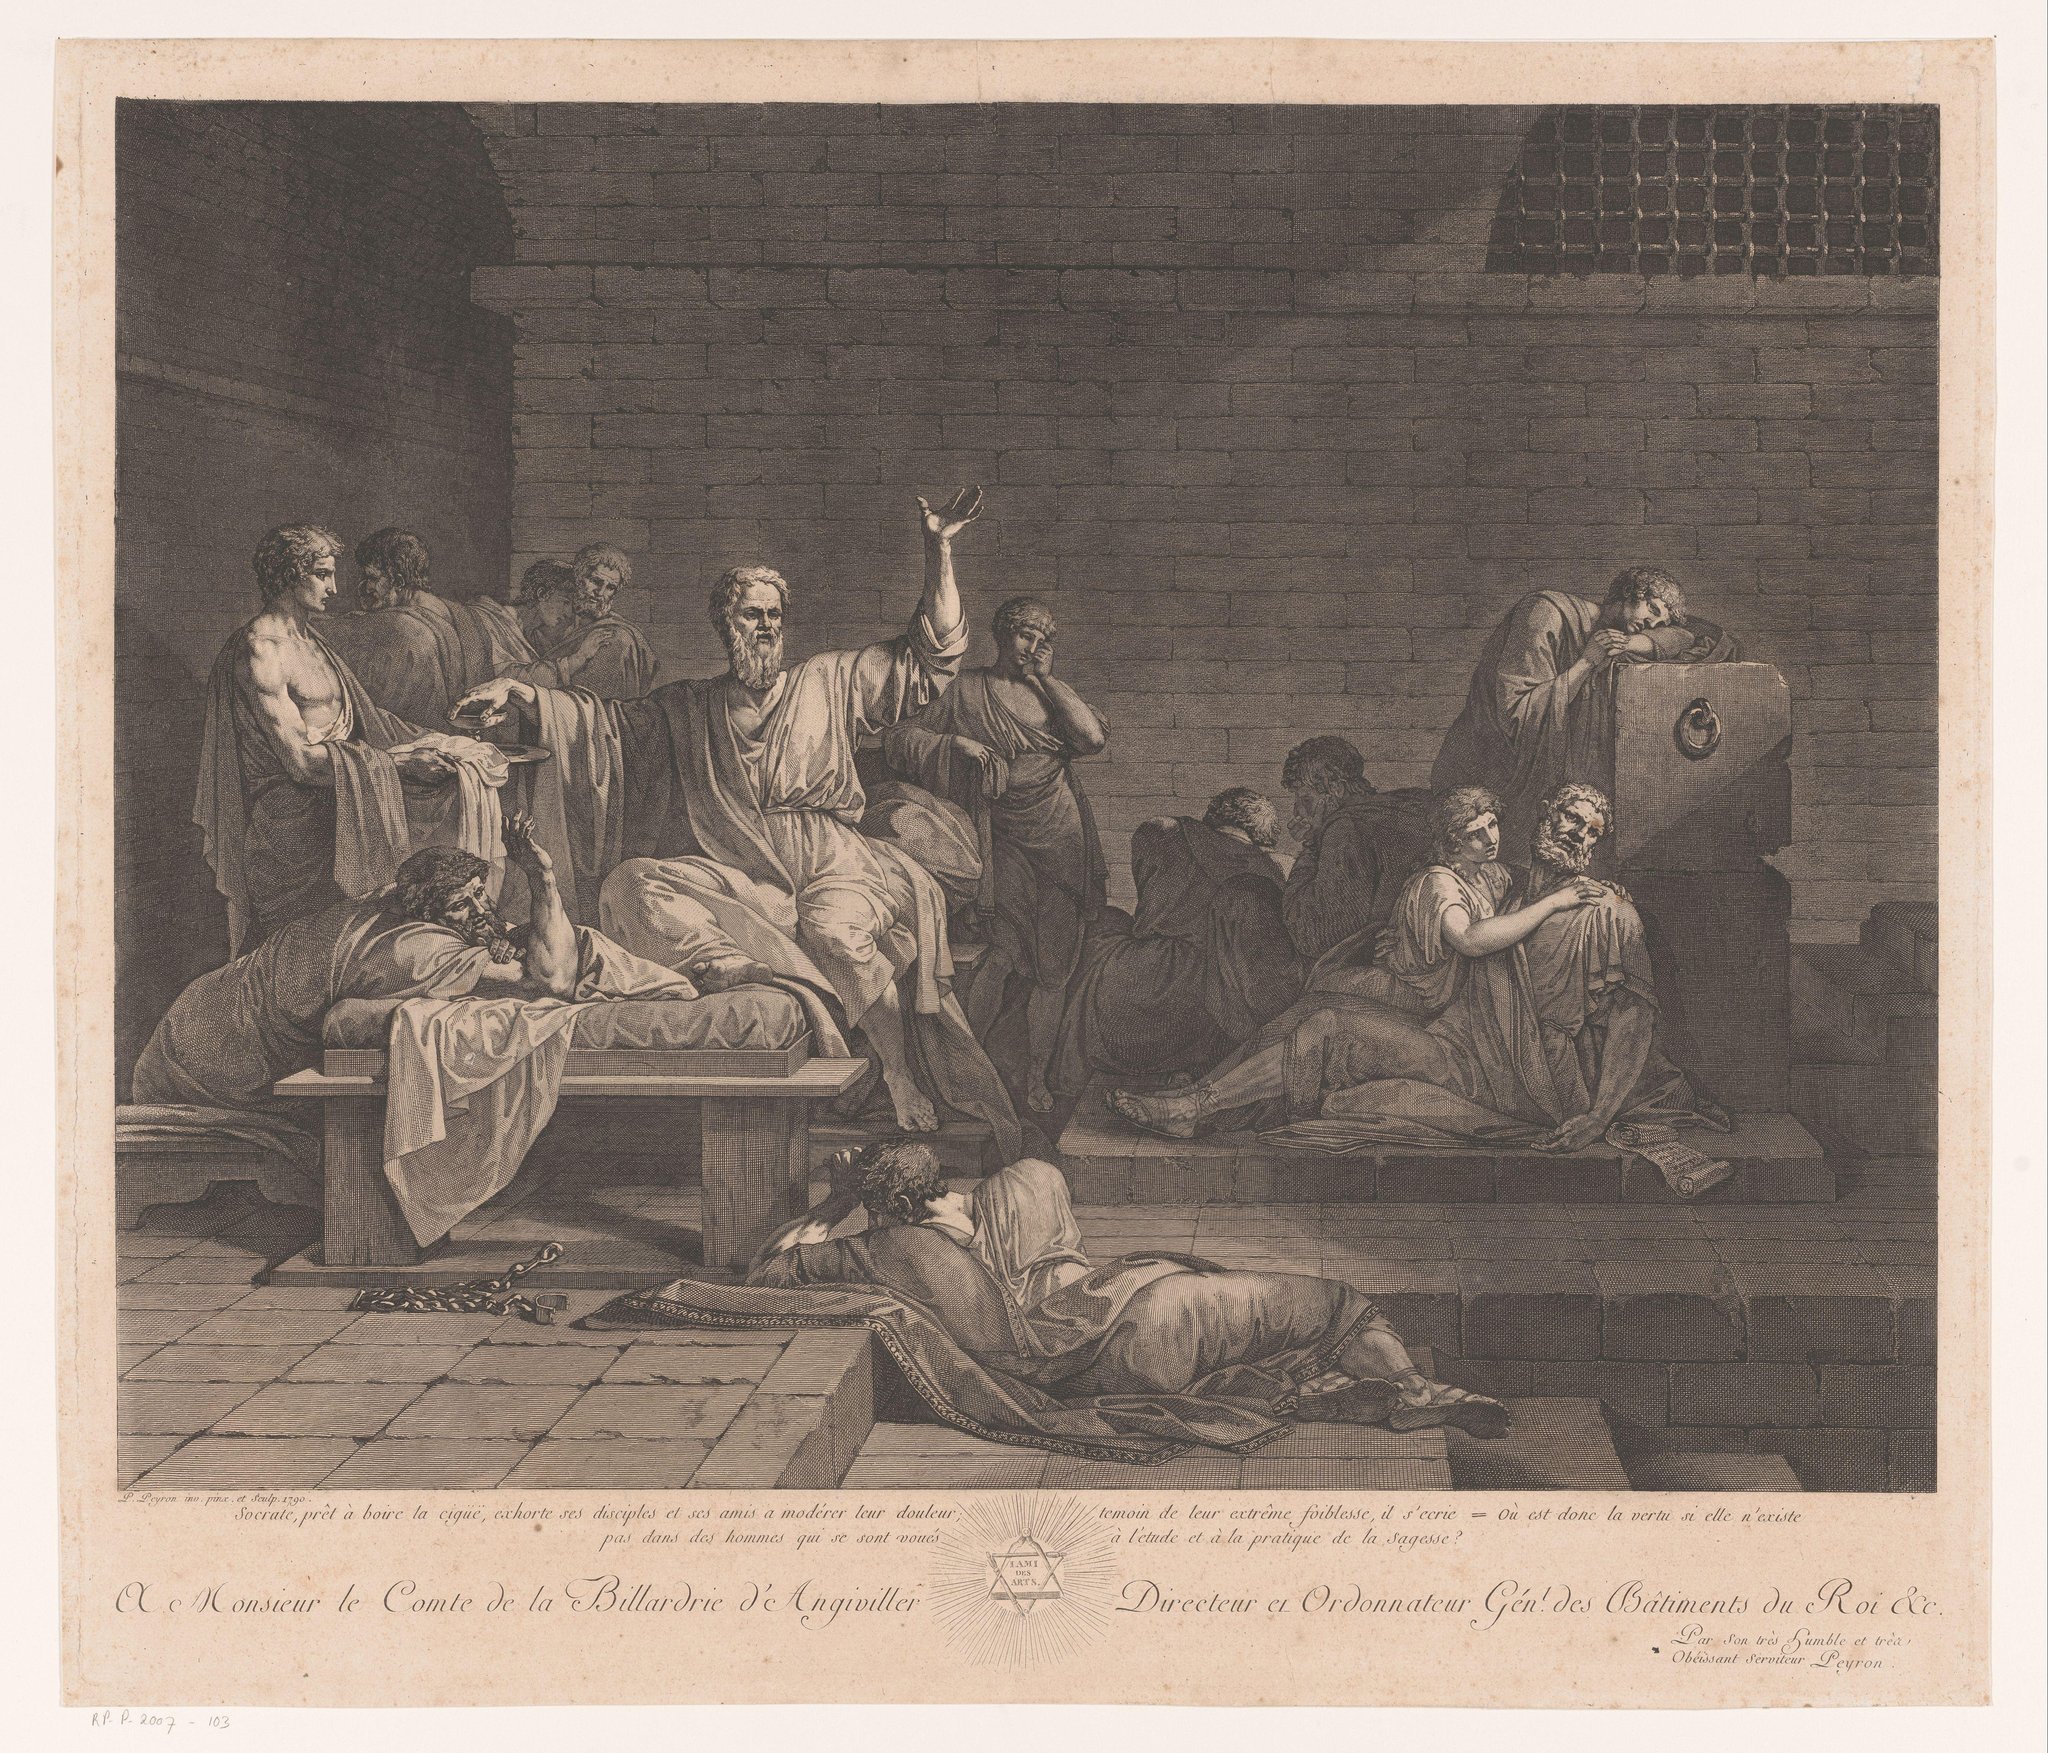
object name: print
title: Socrate, prêt à boire la cigüë (...)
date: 1790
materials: paper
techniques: engraving, etching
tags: death of socrates: in prison, surrounded by his grieving disciples, he calmly drinks the cup of poison after having made a libation to the gods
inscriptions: collector's mark: Lugt 2760, collector's mark: Lugt 2228